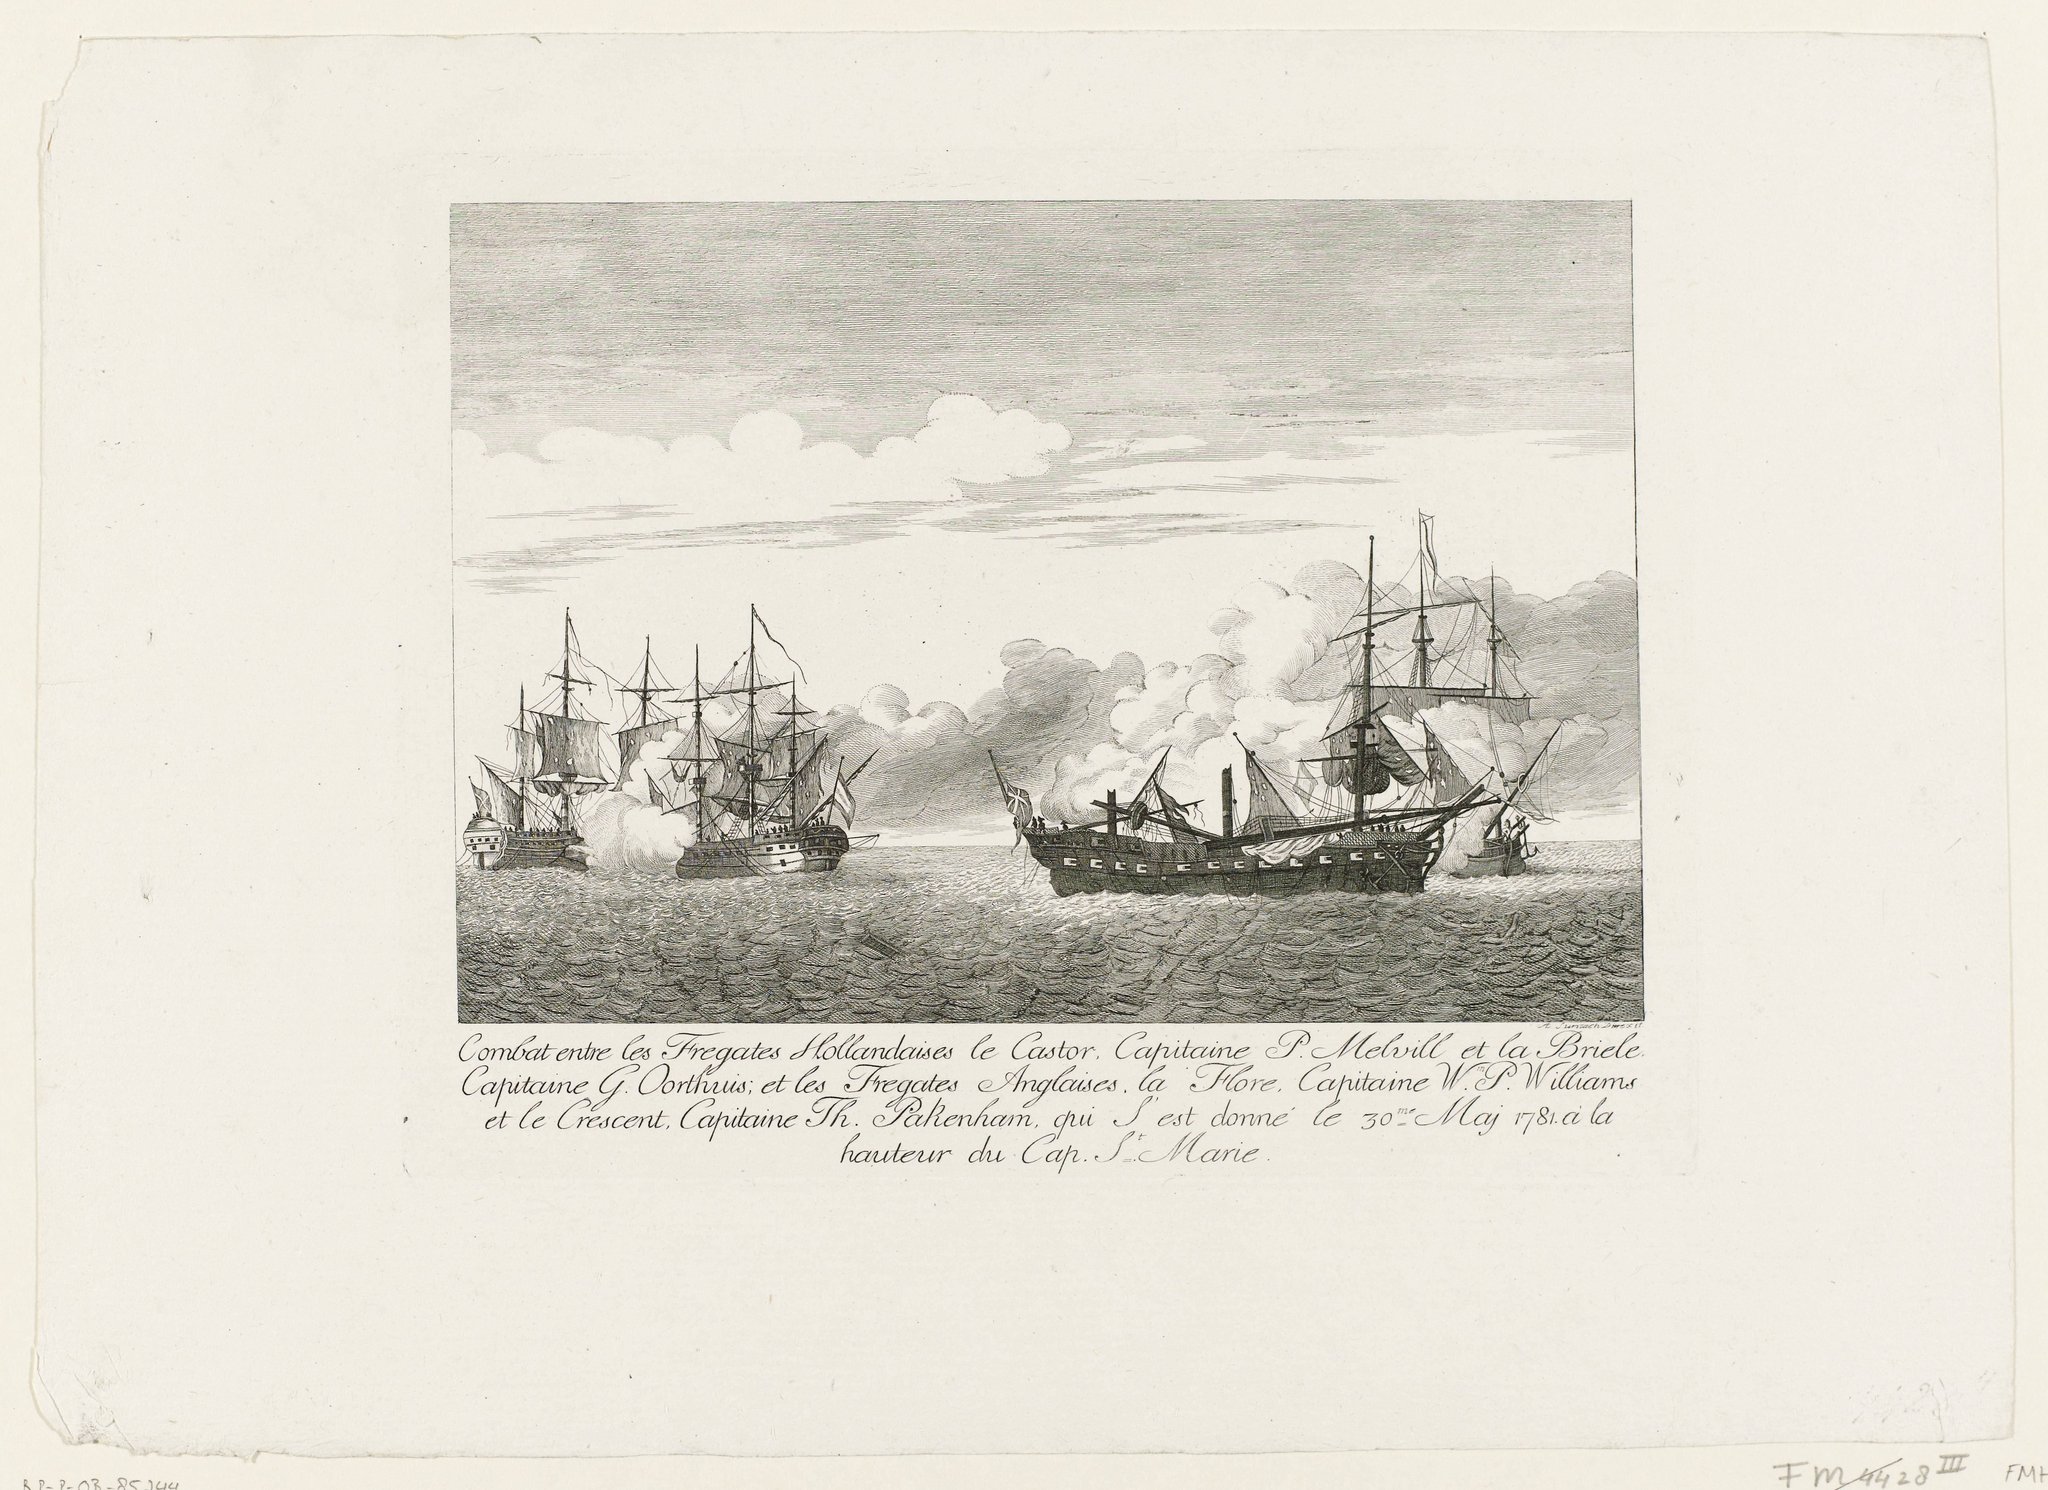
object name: print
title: Combat entre les Fregates Hollandaises le Castor, Capitaine P. Melvill et la Briele Capitaine G. Oorthuis; et les Fregates Anglaises (...) Cap. St. Marie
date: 1782-1790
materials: paper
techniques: engraving, etching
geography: rotterdam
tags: dordrecht, the hague, naval officer, pieter melvill van carnbee, rotterdam, gerardus oorthuys, battle (+ naval force)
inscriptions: collector's mark: Lugt 2228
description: Zeegevecht bij Cadiz tussen twee Nederlandse fregatten Castor en Den Briel en twee Engelse fregatten Flora en Crescent, 30 mei 1781. In de marge de titel in het Frans. Onderdeel van een serie van vier platen van zeeslagen in het jaar 1781.